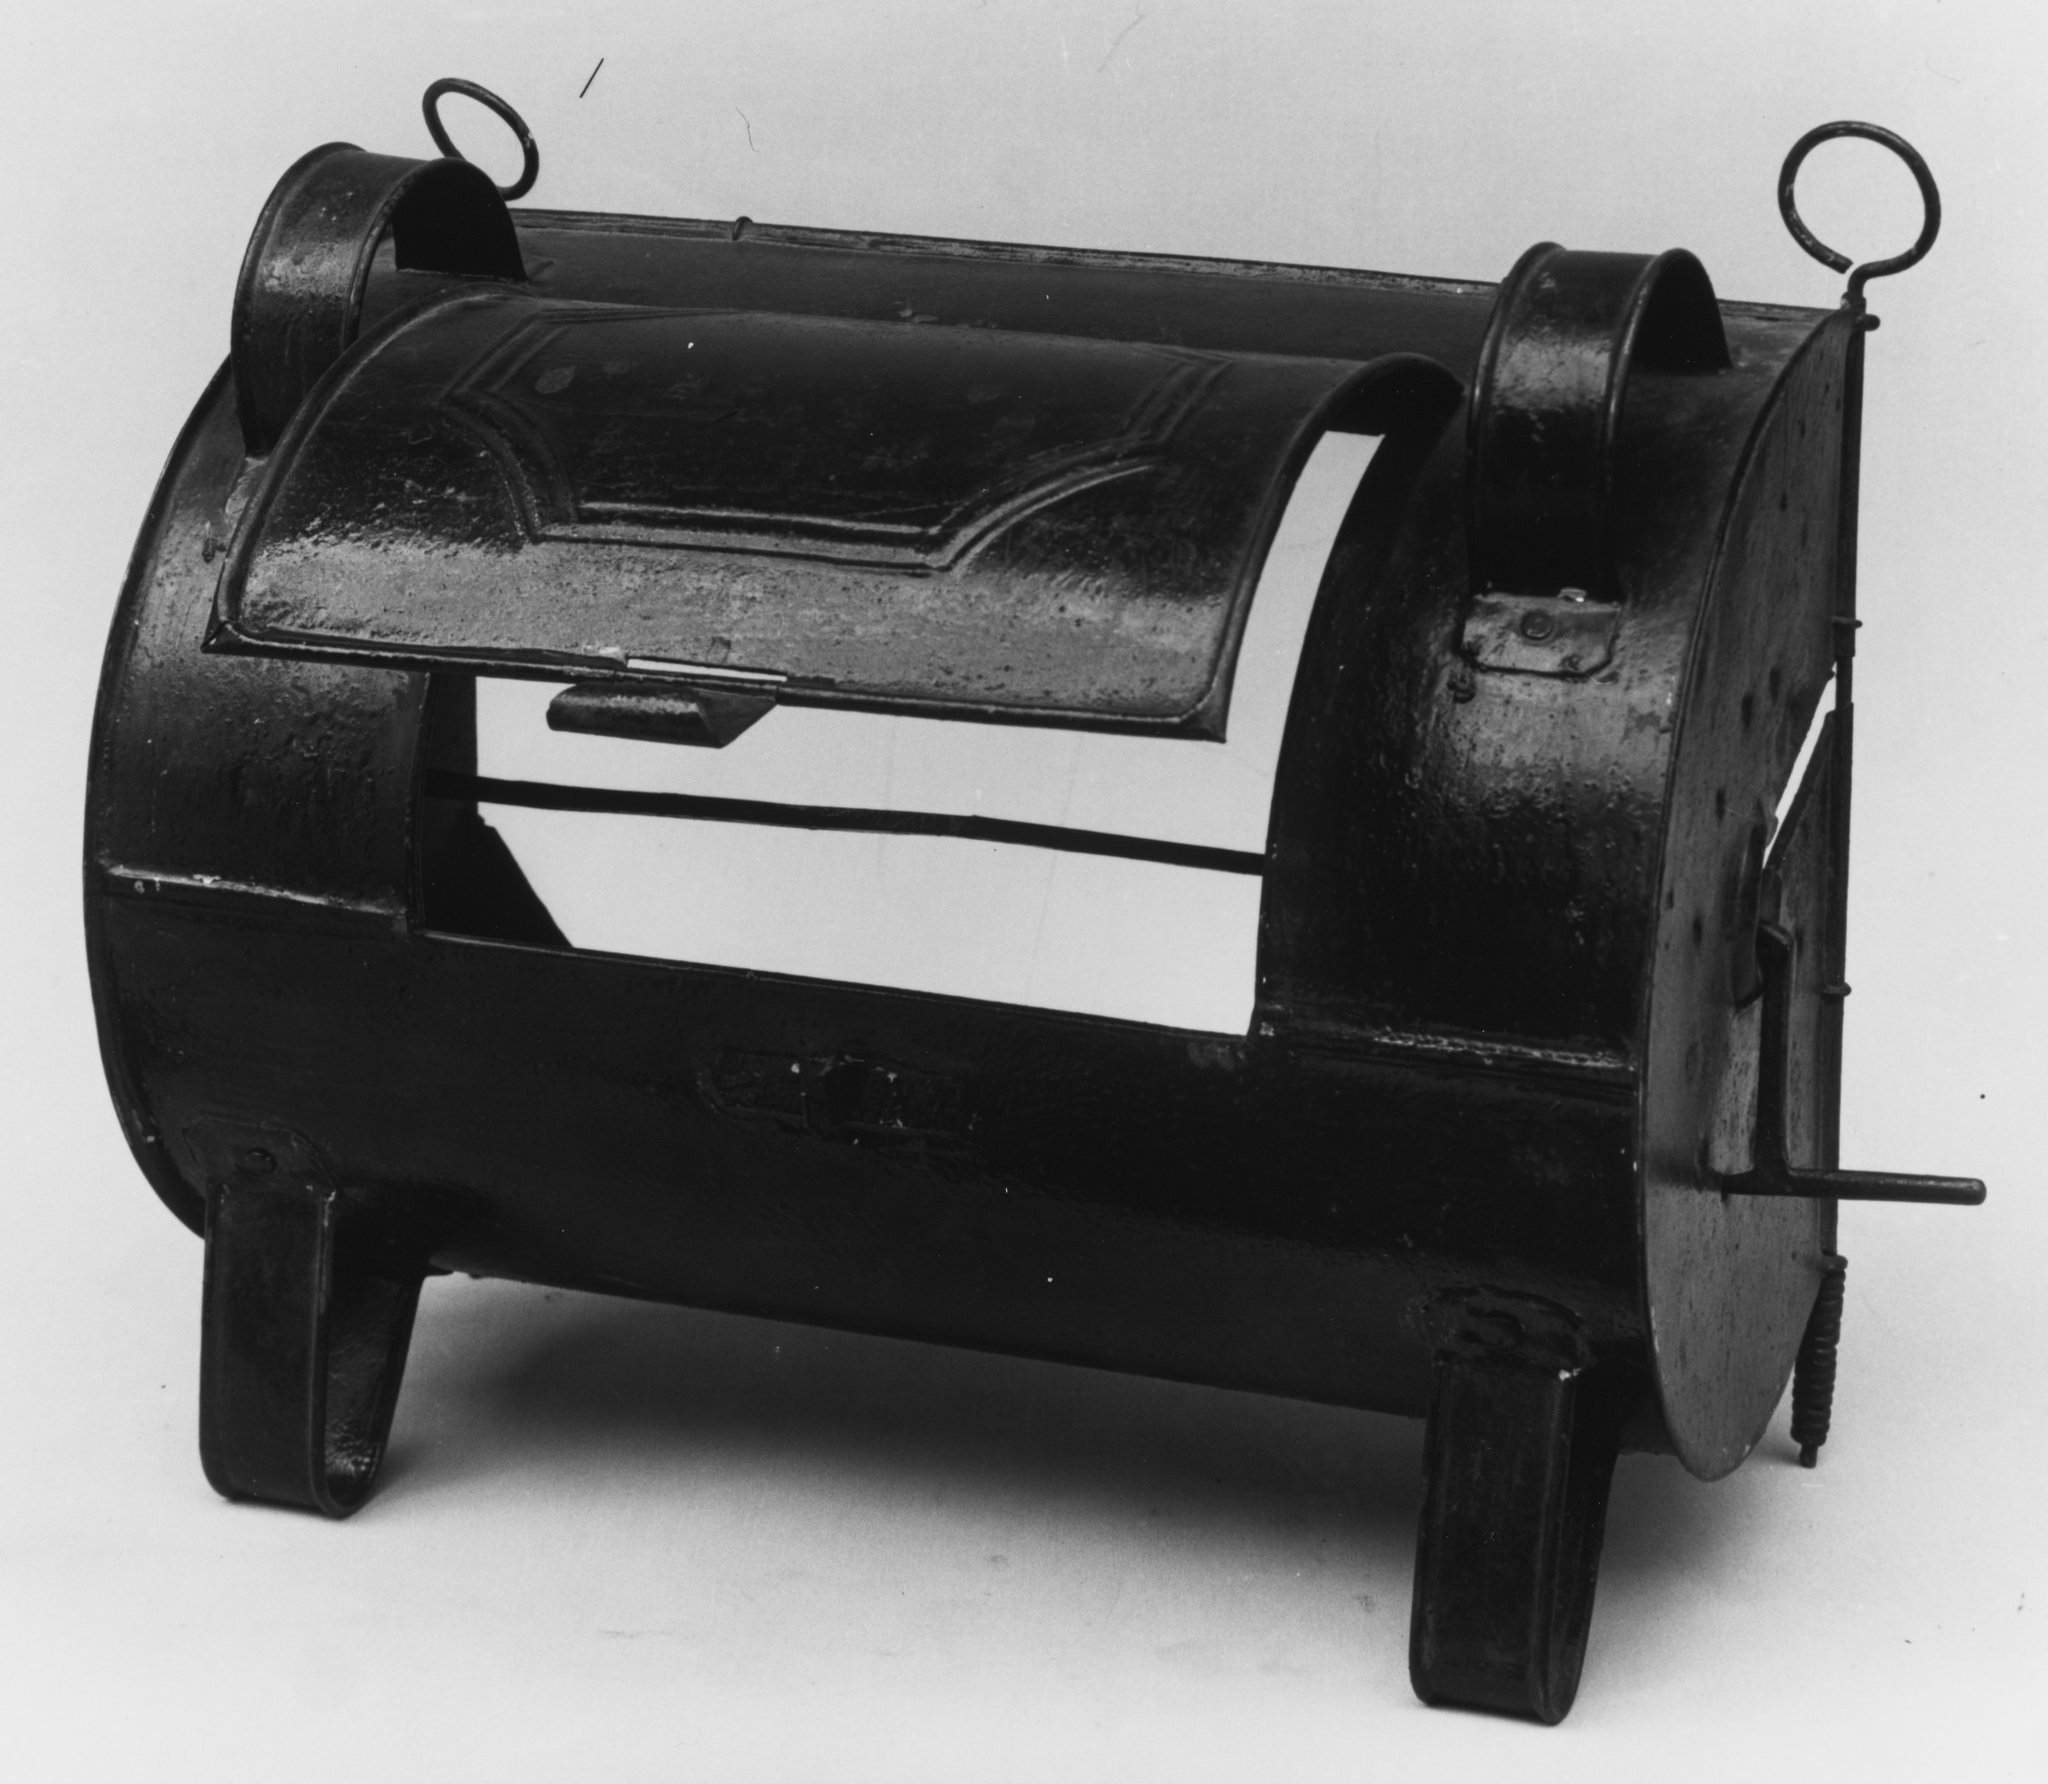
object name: oven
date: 1770-1900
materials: tin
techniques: painting